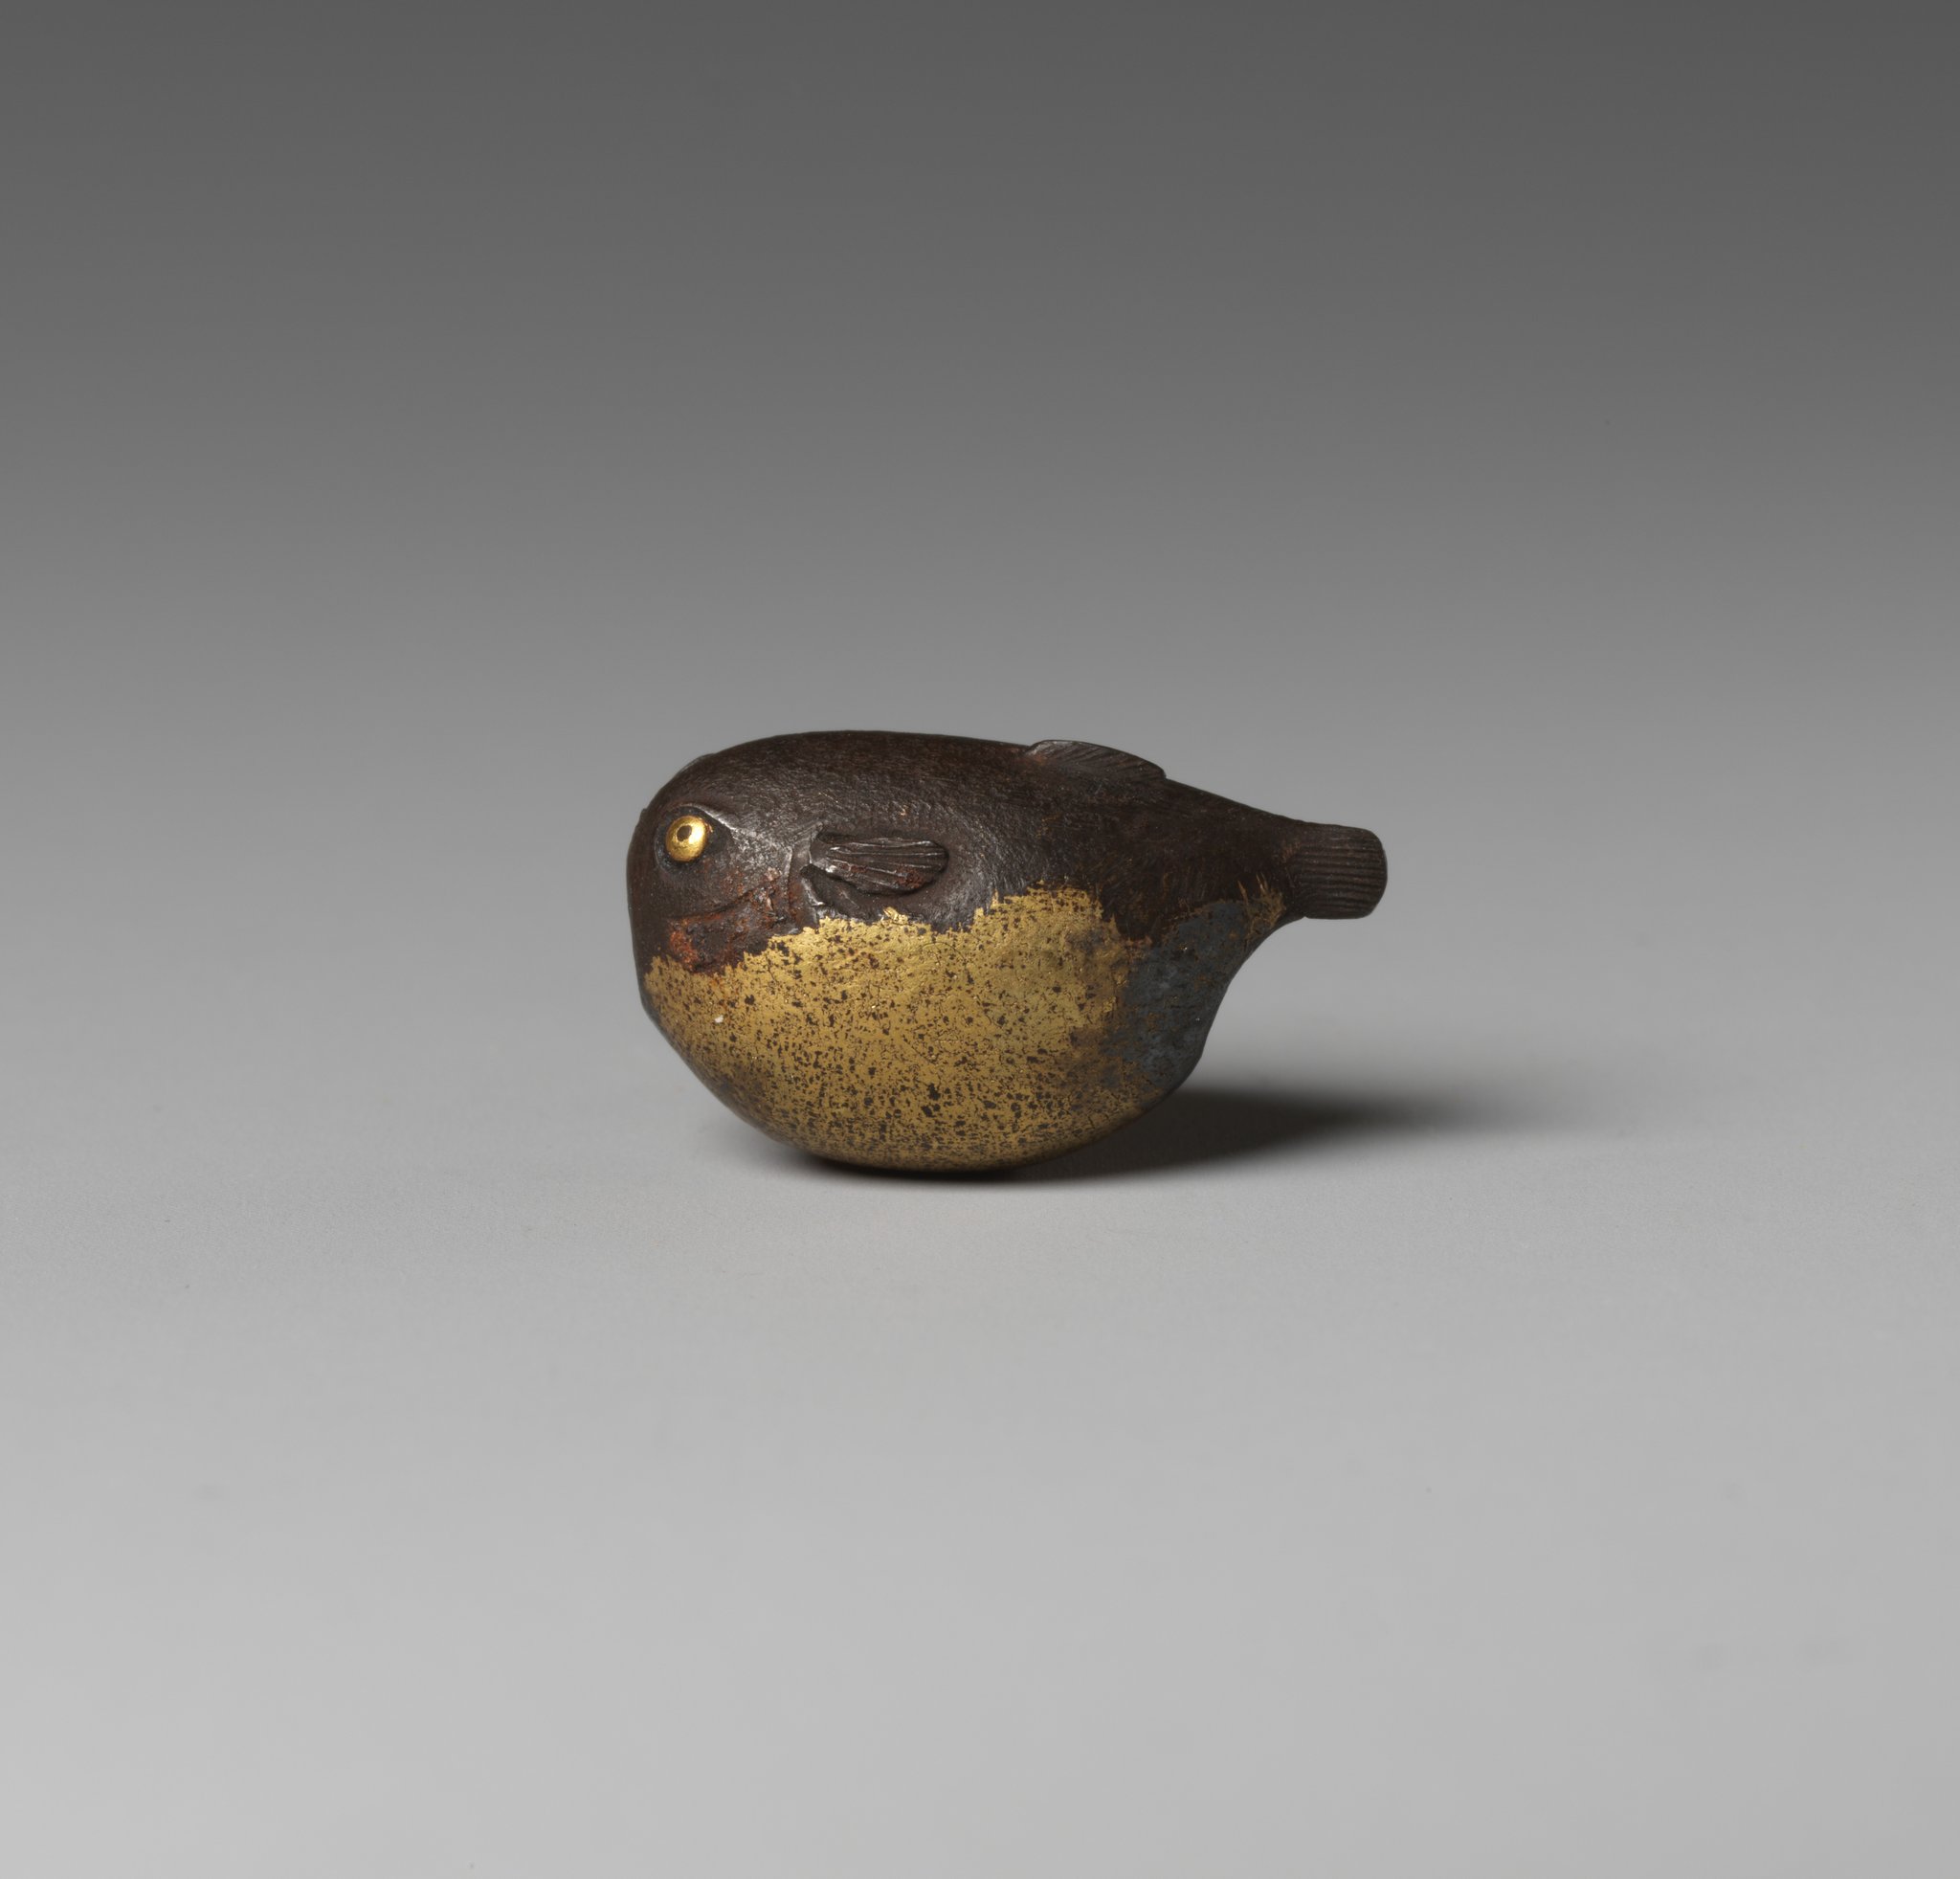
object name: ojime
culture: japanese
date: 1801-1900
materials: lacquer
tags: fish